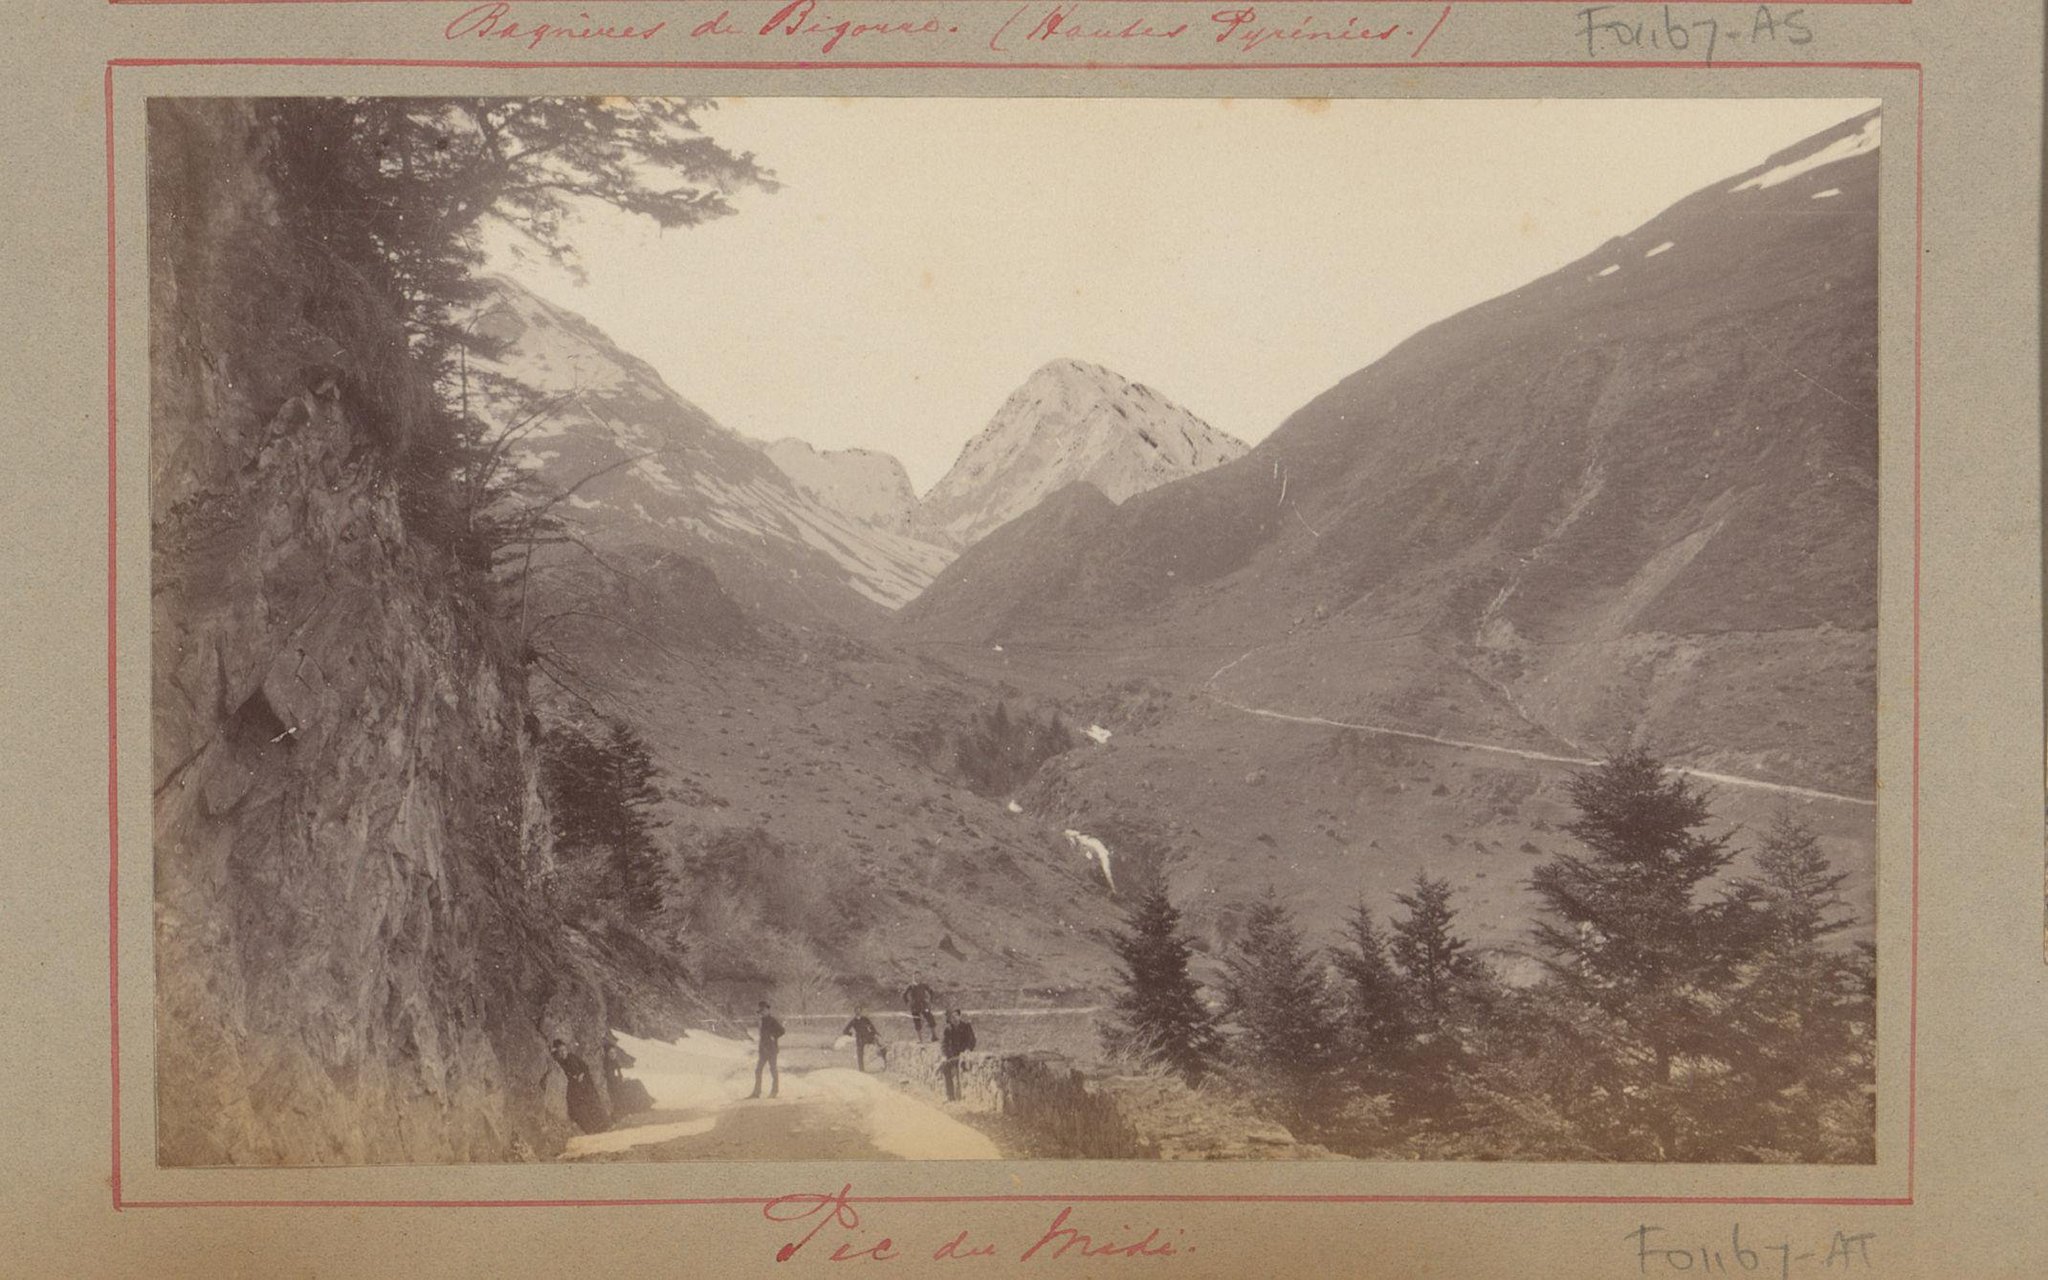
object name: photograph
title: Zes mannen op een bergpas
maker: Anonymous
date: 1880-1910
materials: photographic support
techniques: albumen print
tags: adult man, historical persons, mountains, france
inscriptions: annotation: ‘Pic du midi’